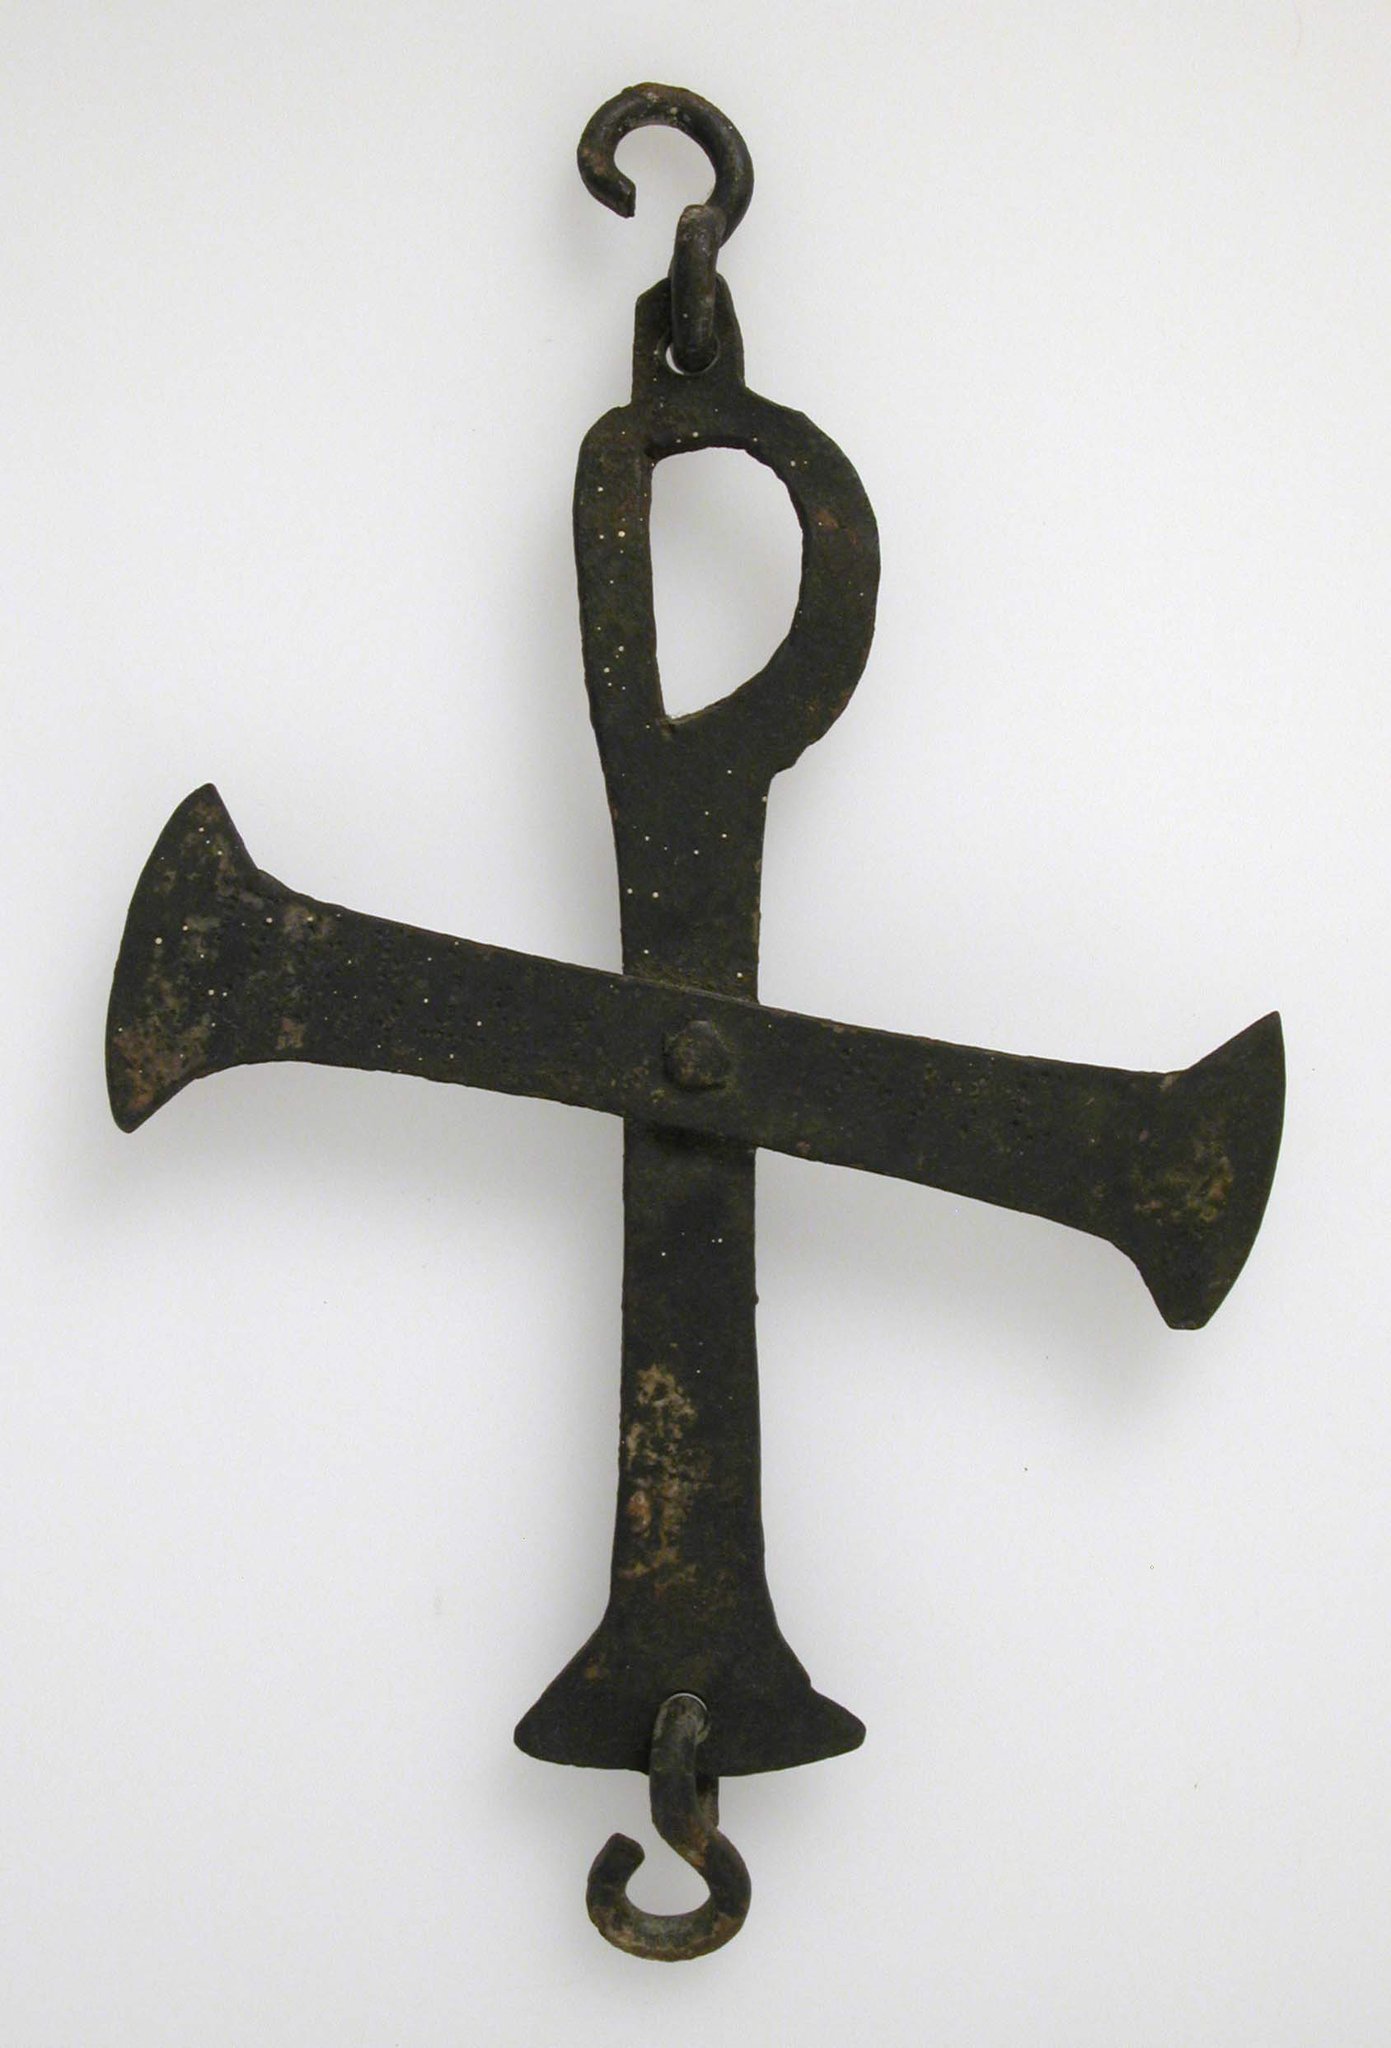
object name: cross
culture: byzantine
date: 501-600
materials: copper alloy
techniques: casting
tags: cross